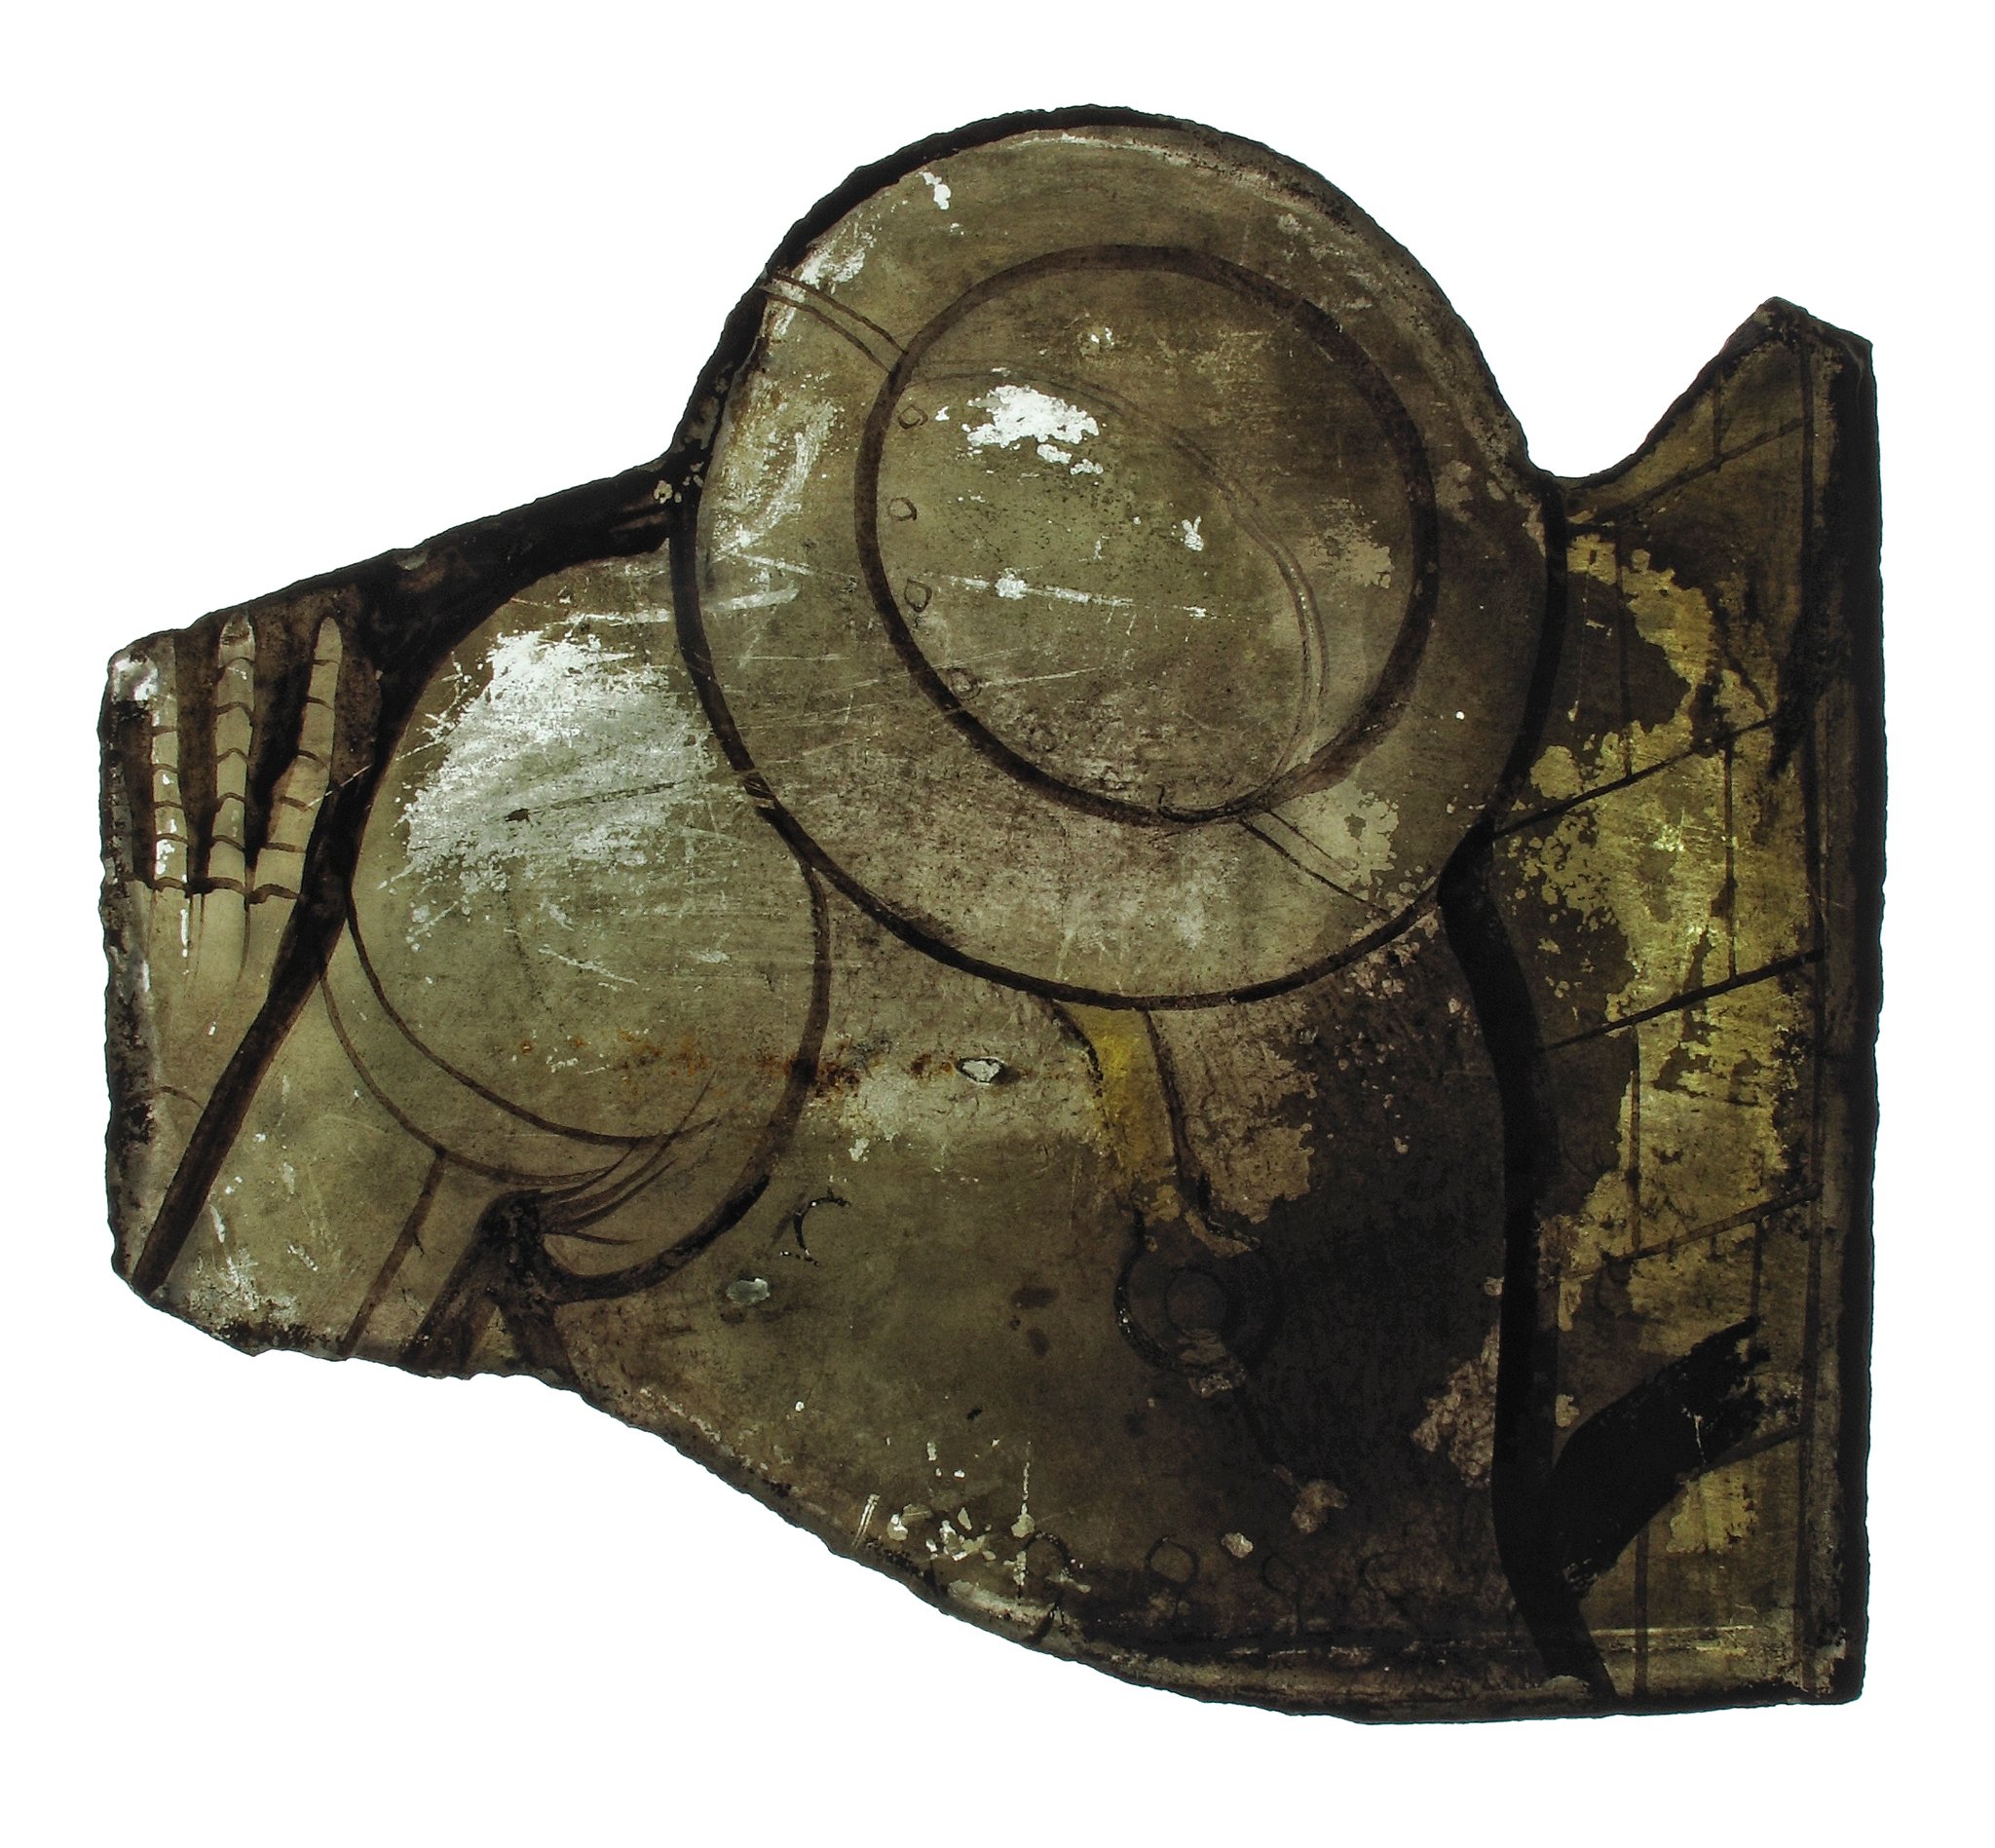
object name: fragment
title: Glass Fragment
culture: european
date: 1467-1500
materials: glass